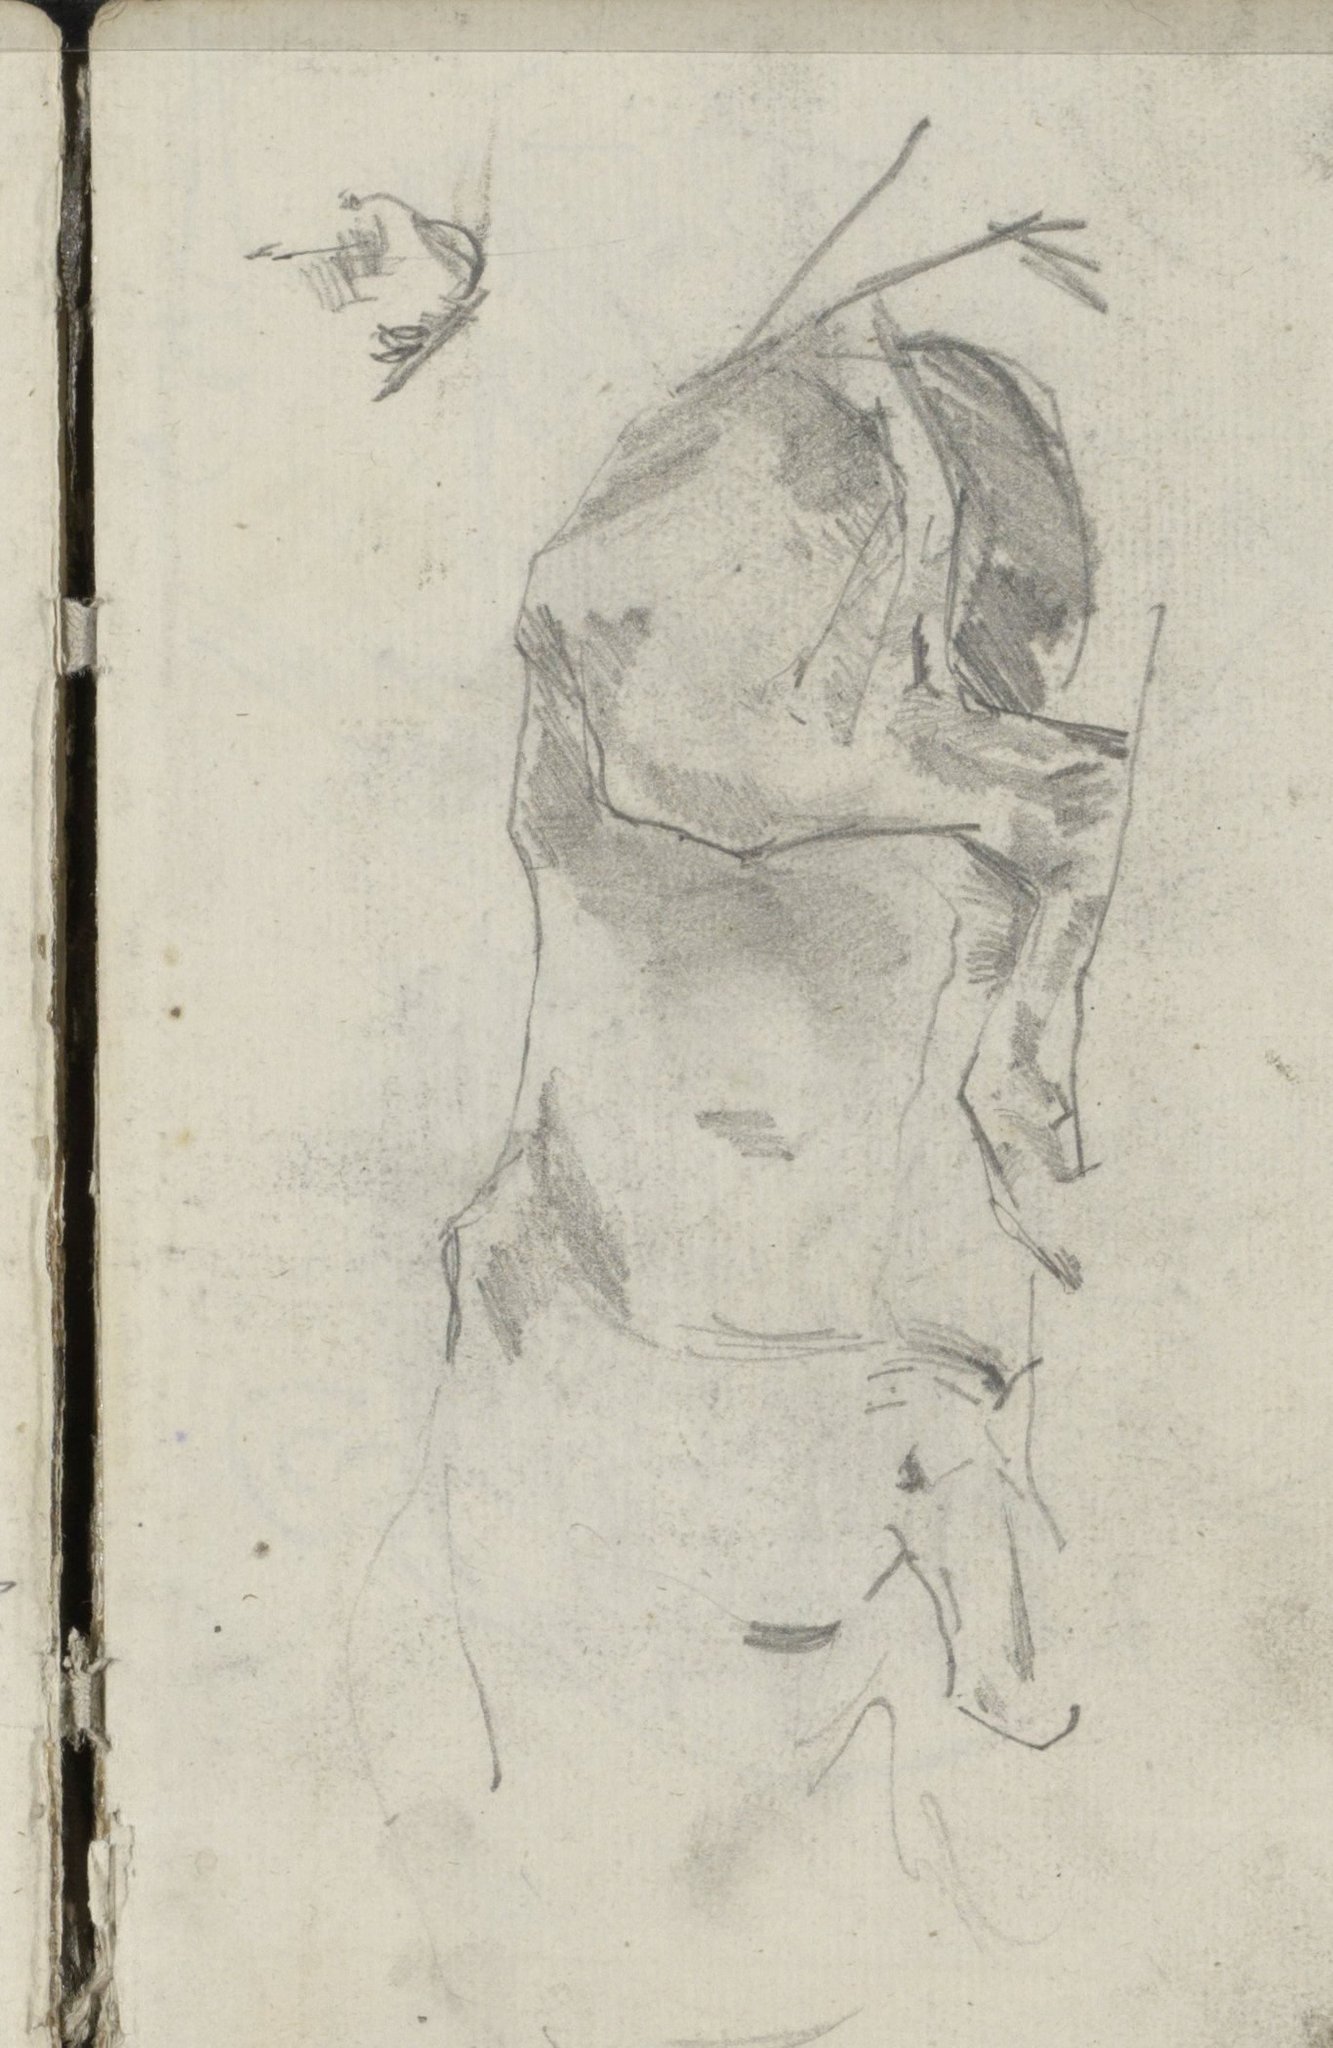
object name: sketchbook leaf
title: Liggend paard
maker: george hendrik breitner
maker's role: draughtsman, painter, print maker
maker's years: 1857-1923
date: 1881-1883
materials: paper, pencil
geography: the hague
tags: horse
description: Pagina 6 uit een schetsboek met 27 bladen.